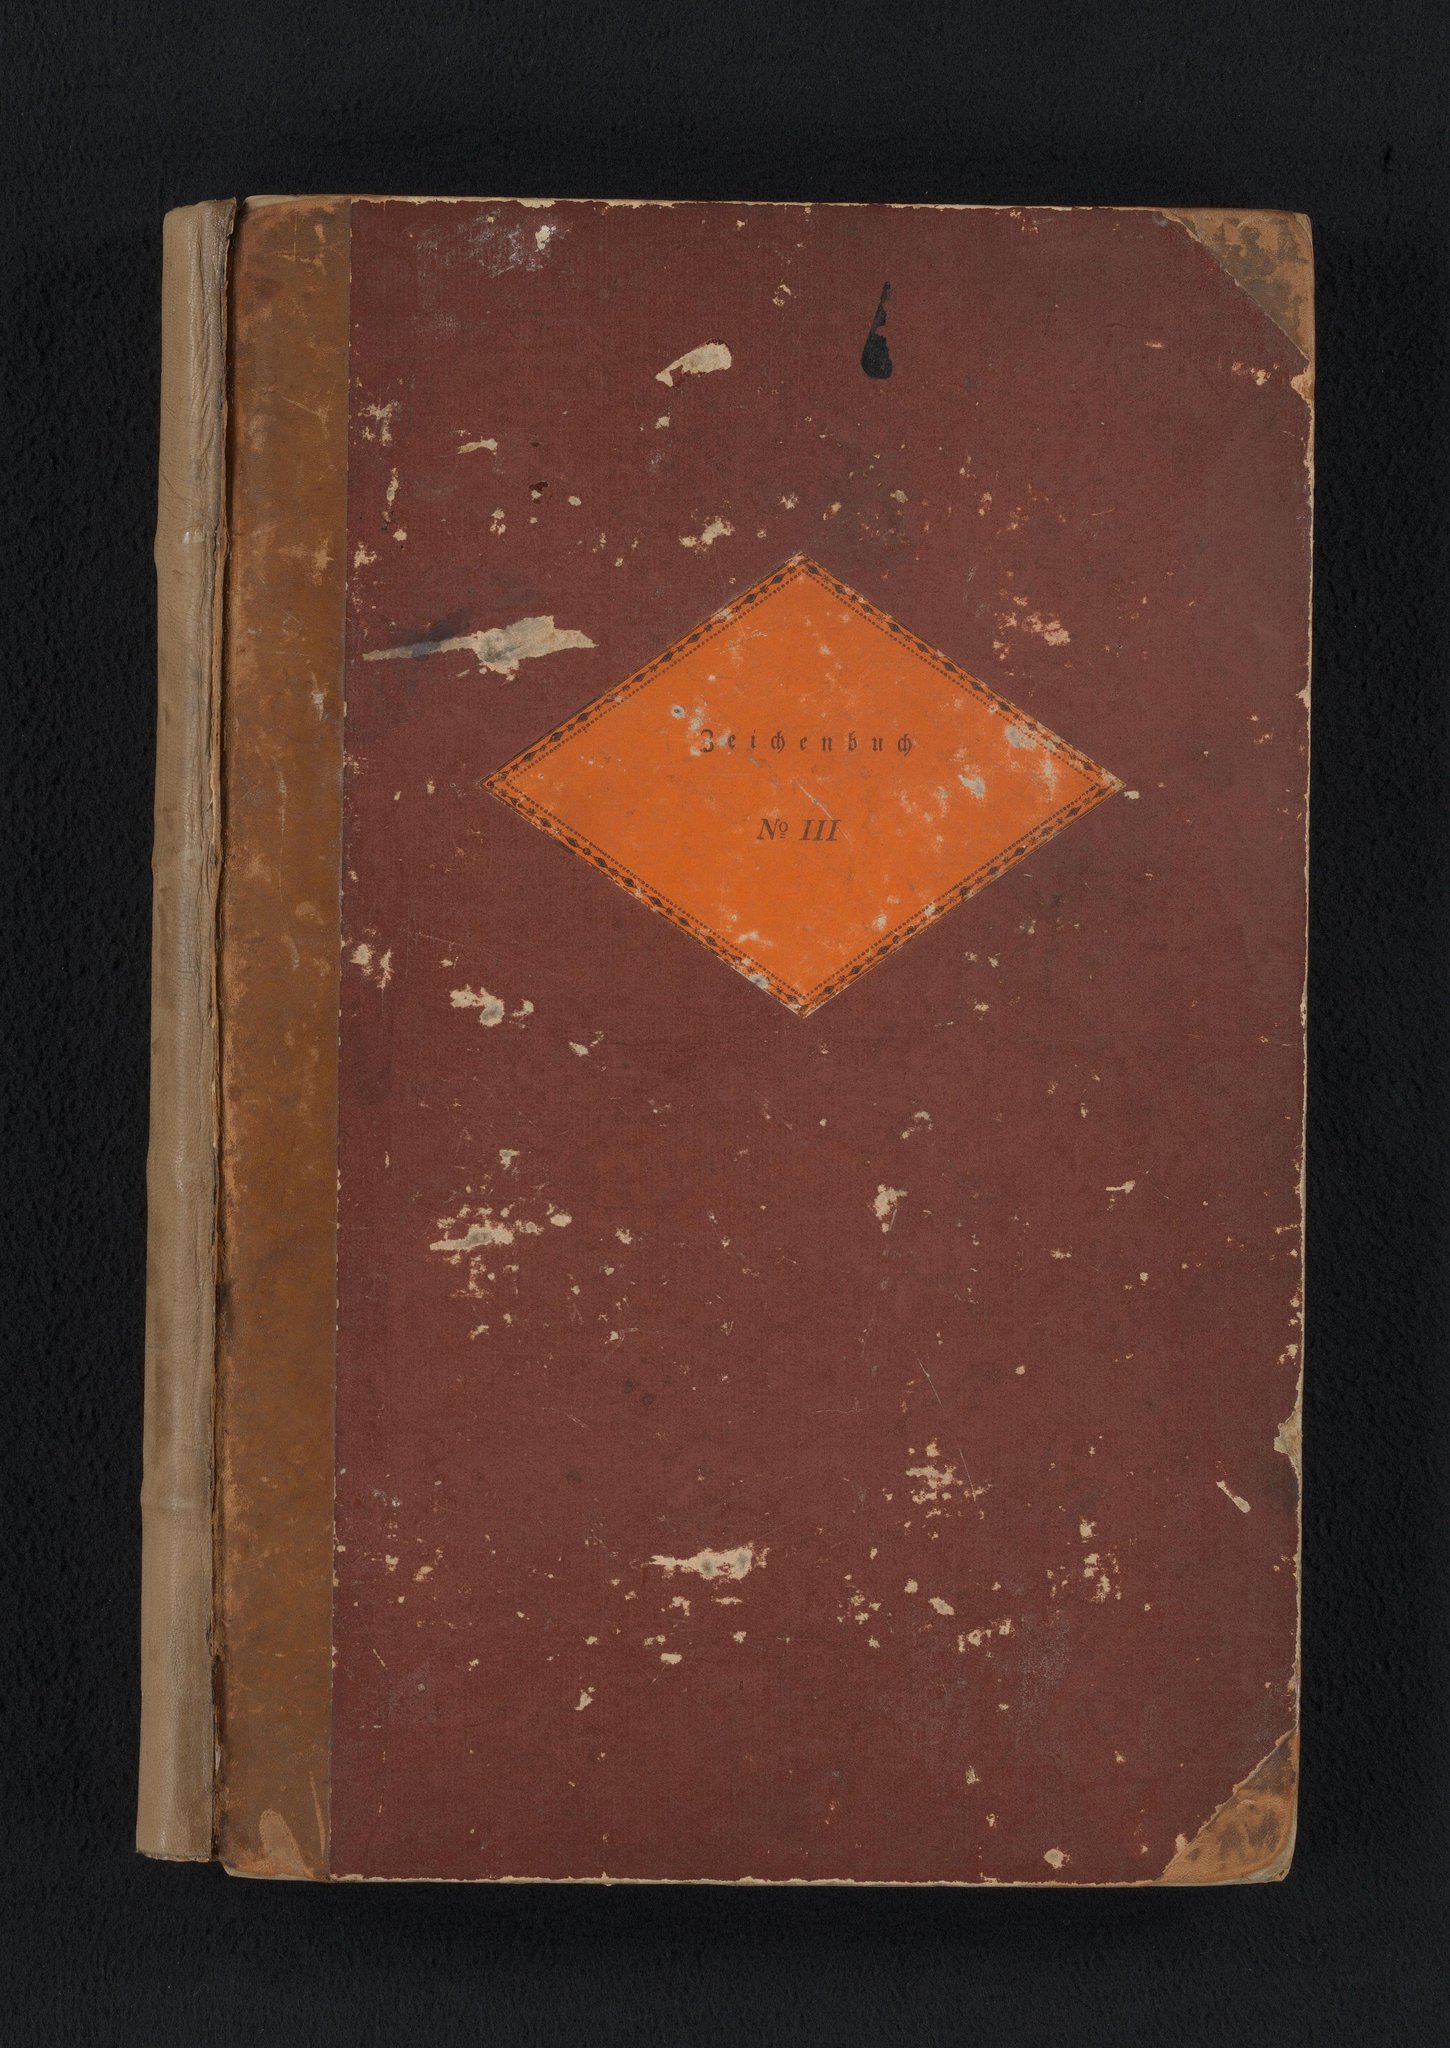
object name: prentrecueil, prentenalbum, prentalbum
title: Zeichenbuch, Vorlegeblatter und Ideen in den verschiedenen Gegenständen der Zeichnenden Kunst. No. 3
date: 1816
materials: paper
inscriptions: collector's mark: Briquet 2760, collector's mark: Lugt 2228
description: Album (nr. 3) met tekenvoorbeelden. De rectobladen van het album zijn beplakt met prenten uit 18de-eeuwse tekenboeken, portret-, ornament- en architectuurprenten en tekeningen. Het album bevat 69 beplakte bladen, gevat in originele band met leren rug en hoeken en opgeplakt etiket.